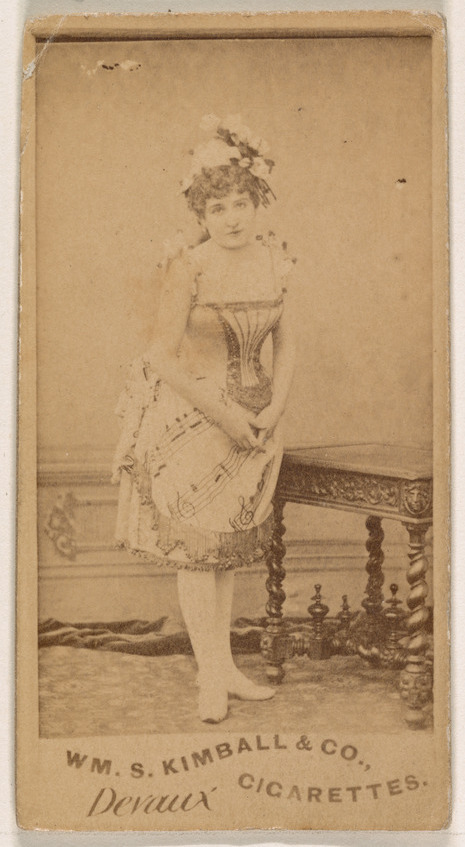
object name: photograph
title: Miss Devaux, from the Actresses series (N203) issued by Wm. S. Kimball & Co.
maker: william s. kimball & company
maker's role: publisher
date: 1889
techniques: color lithograph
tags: portraits,women,actresses